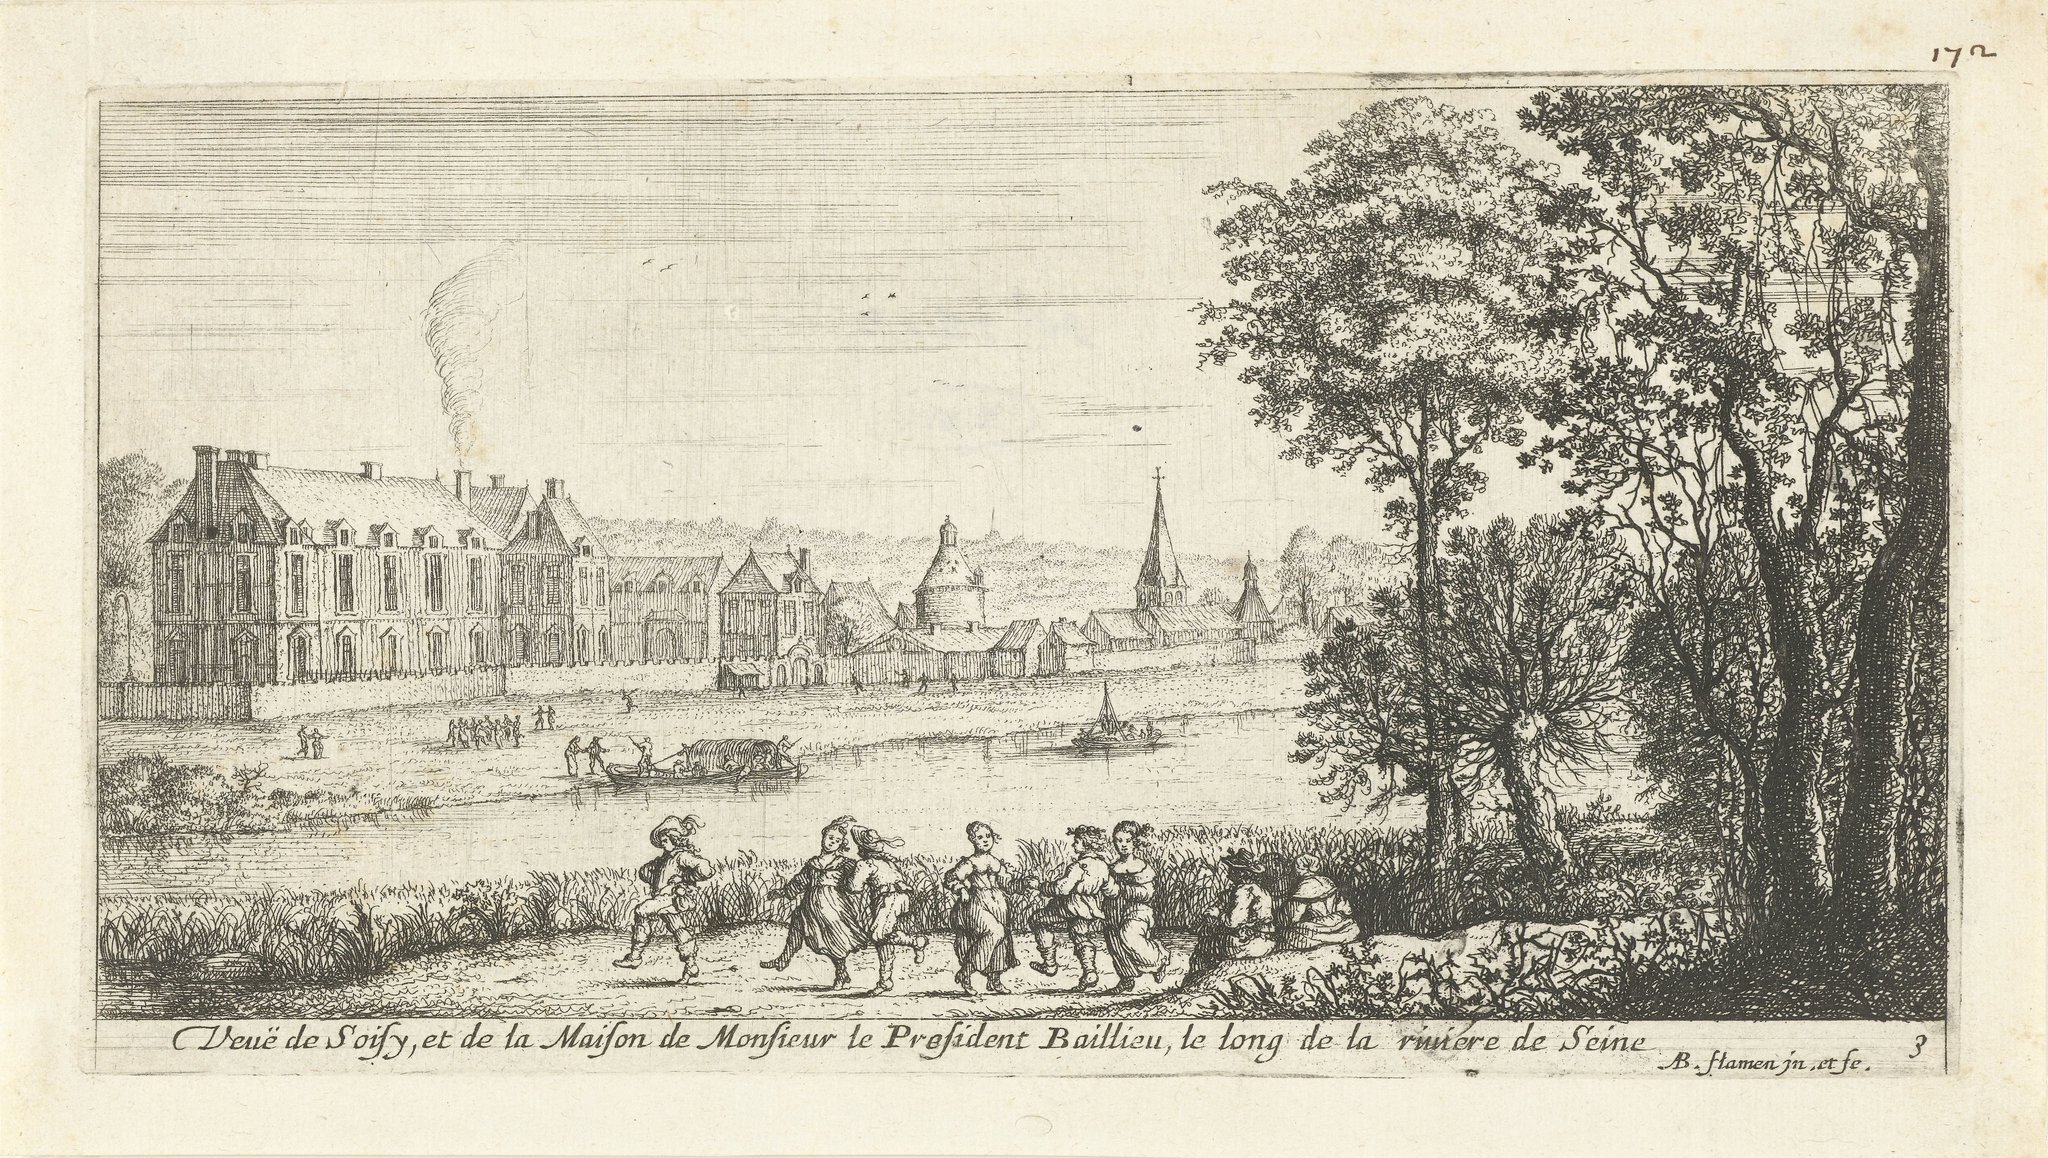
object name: print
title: Veuë de Soisy, et de la Maison de Monsieur le President Baillieu (...)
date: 1648-1672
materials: paper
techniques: etching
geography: france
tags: soisy-sur-seine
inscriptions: collector's mark: Lugt 2161, collector's mark: Lugt 2228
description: Dansende mannen en vrouwen aan de oever van de rivier de Seine. Op de achtergrond een groot landhuis en de kerktoren van Soisy.